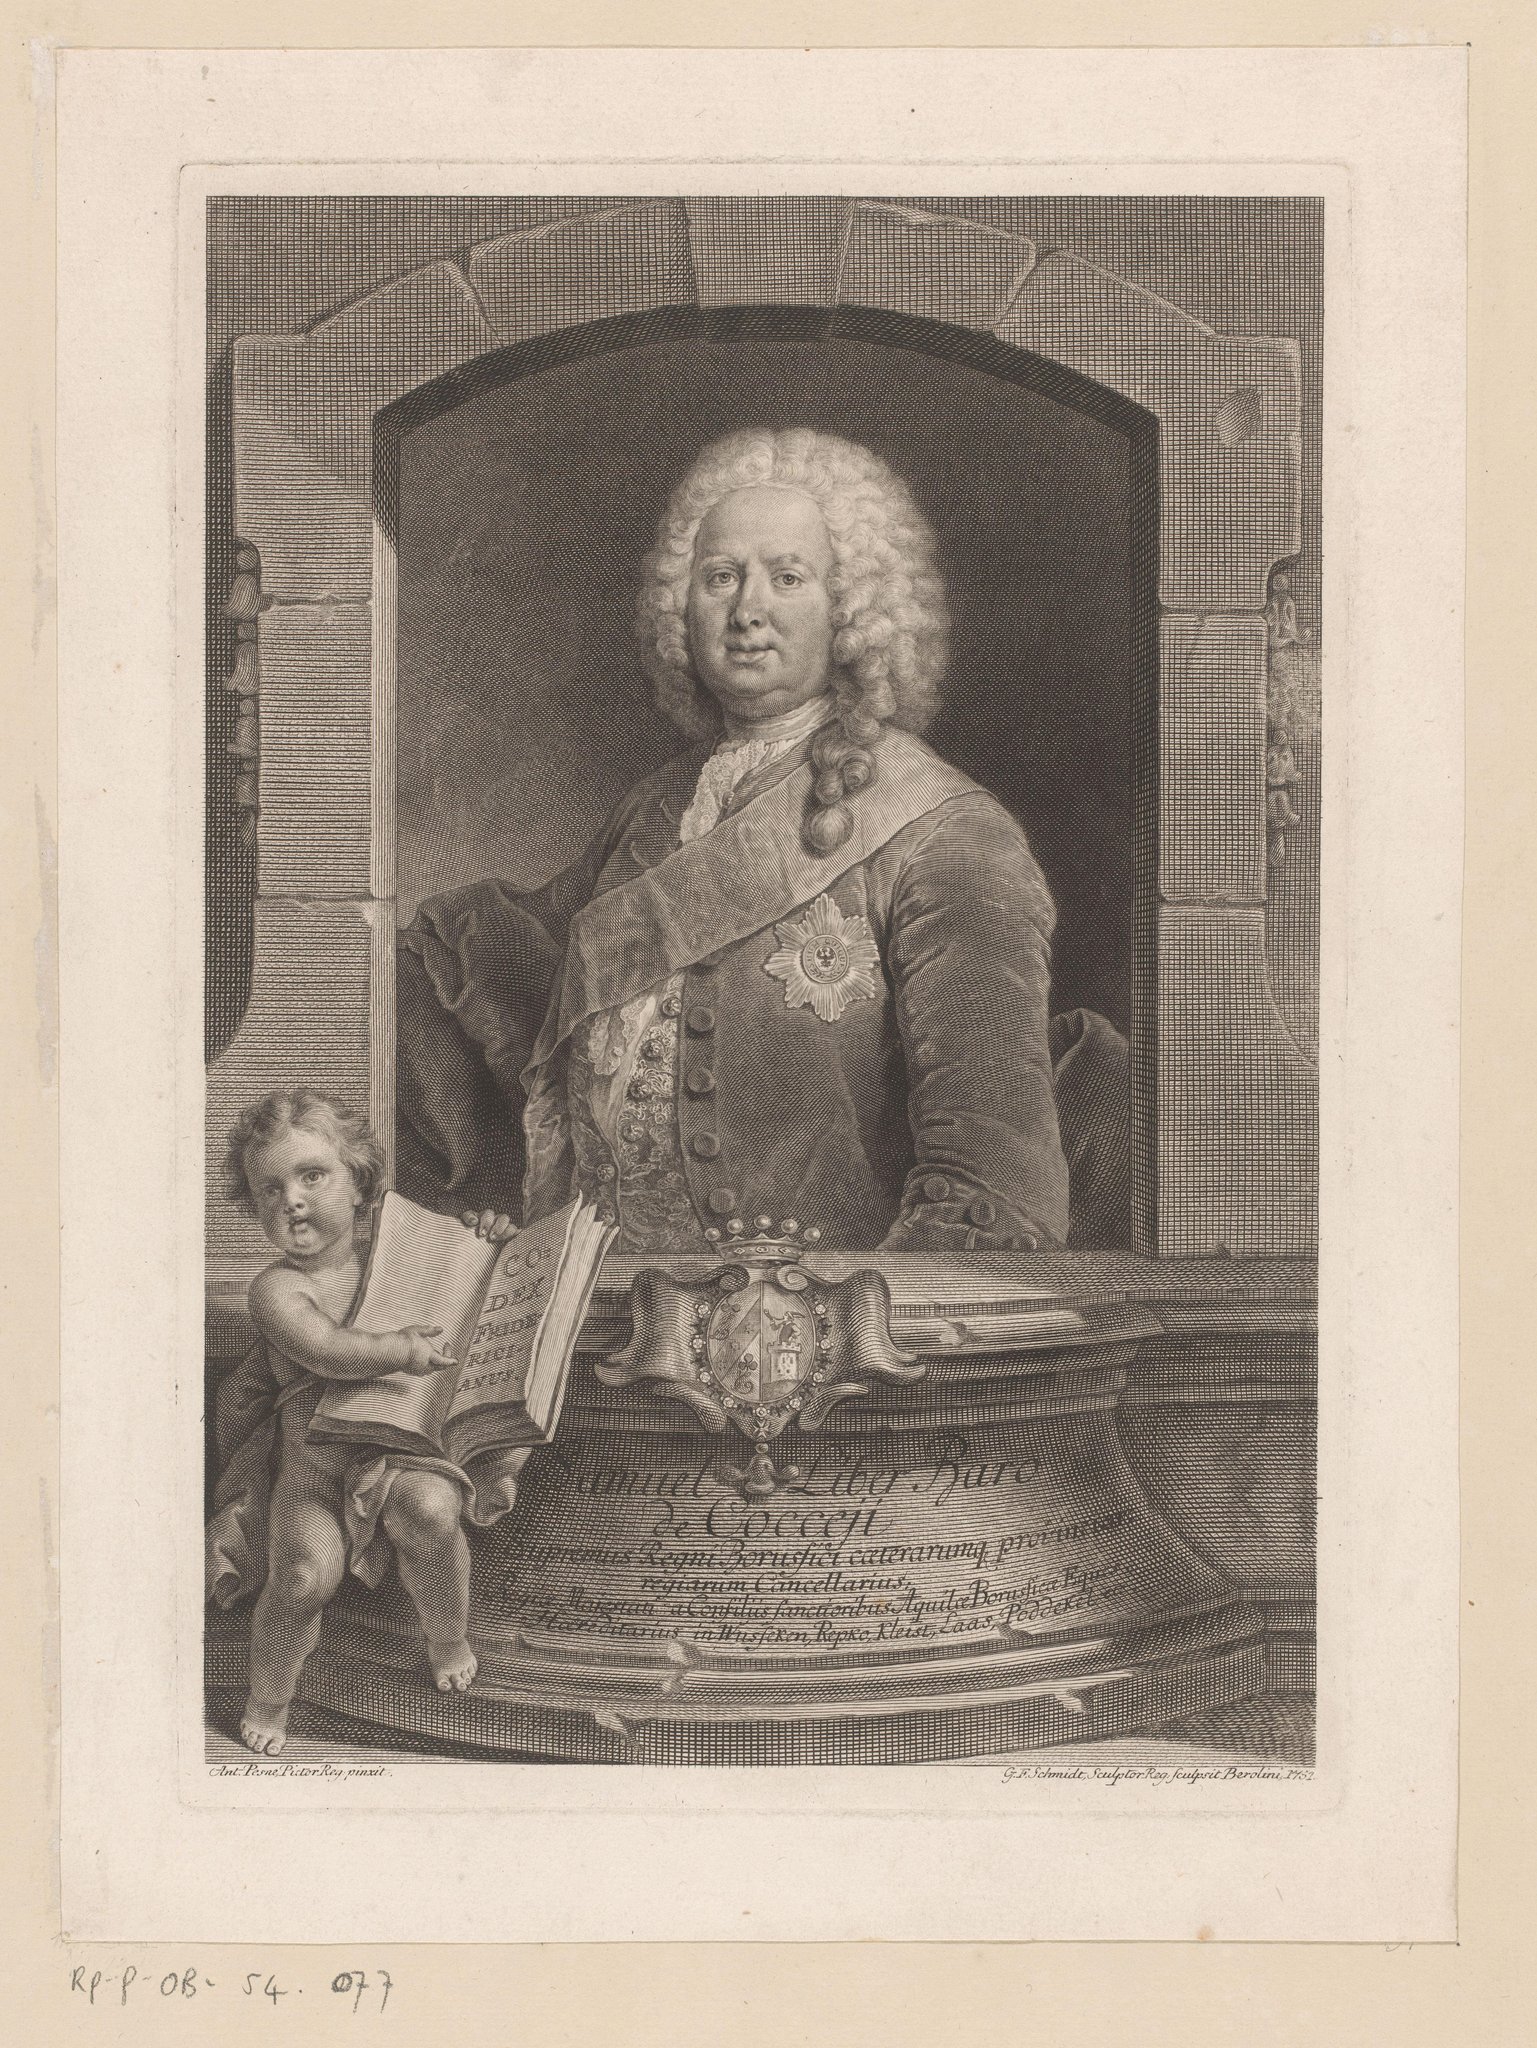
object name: print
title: Portret van Samuel, Freiherr von Cocceji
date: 1751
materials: paper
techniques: engraving, etching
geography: berlin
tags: berlin, historical persons, armorial bearing, heraldry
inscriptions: collector's mark: Lugt 240